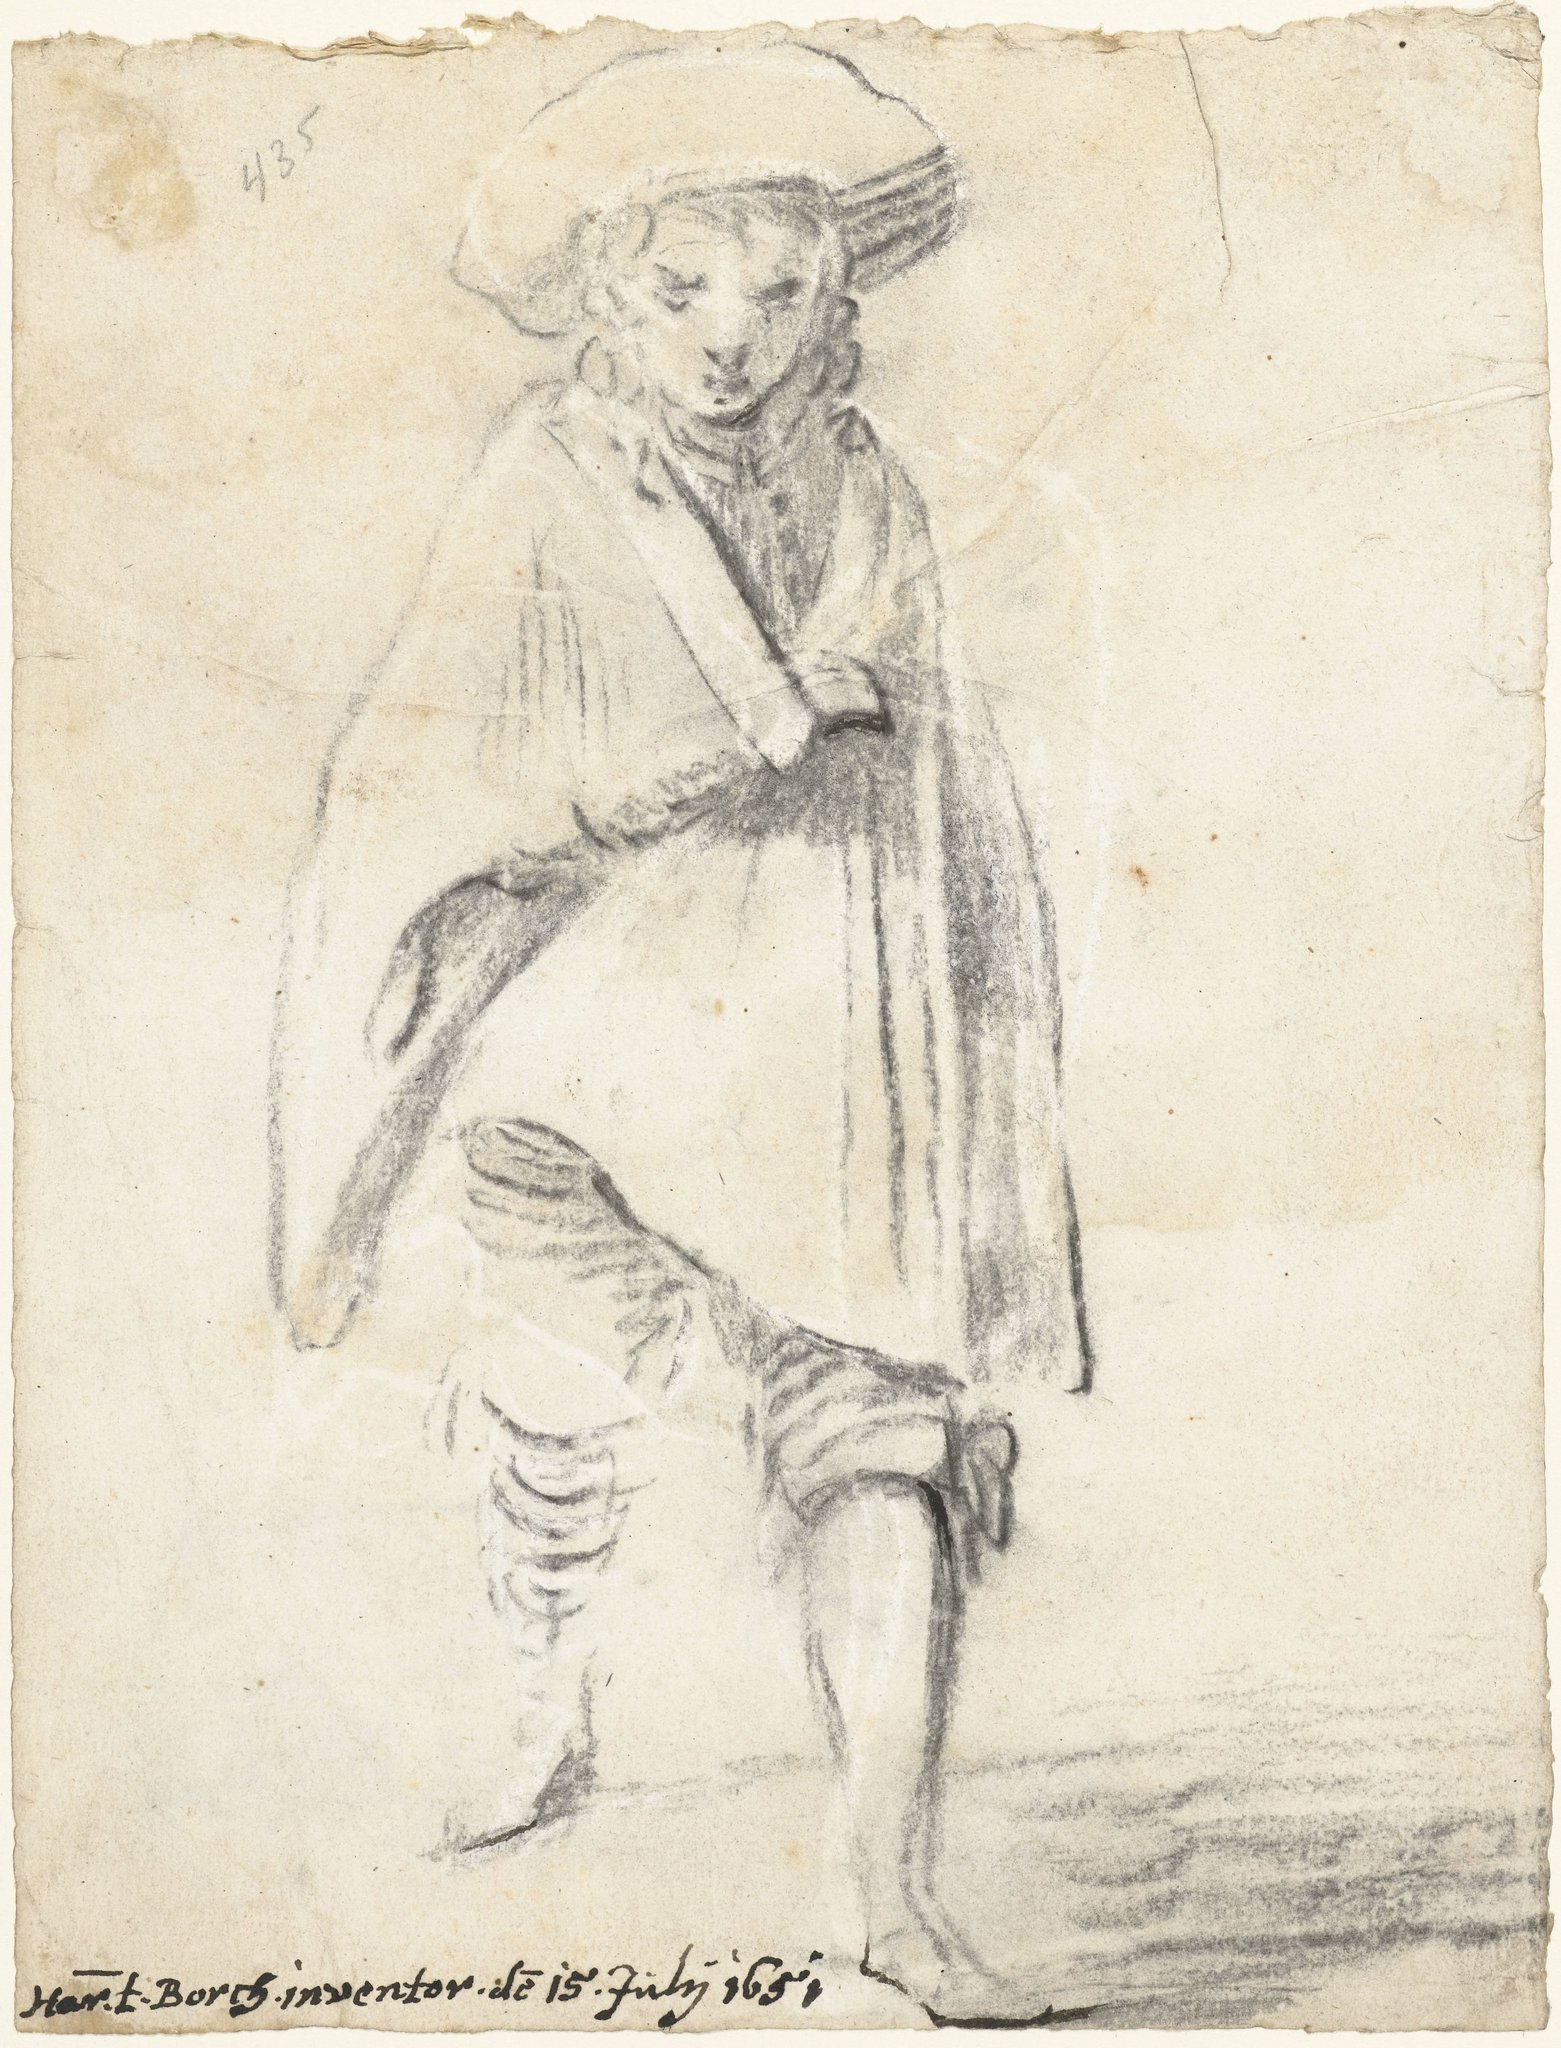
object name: drawing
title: Staande figuur van een jongeman met een mantel om zich heen geslagen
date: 1651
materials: chalk, ink, paper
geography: zwolle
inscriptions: annotation: ‘Har[man].t.Borch. inventor. de[n] 15.Julij 1651’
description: Sommige delen (de voeten, knieën en handen) zijn geaccentueerd met pen in bruin, aangebracht in dezelfde inkt als het opschrift, mogelijk door Gerard de Oude.